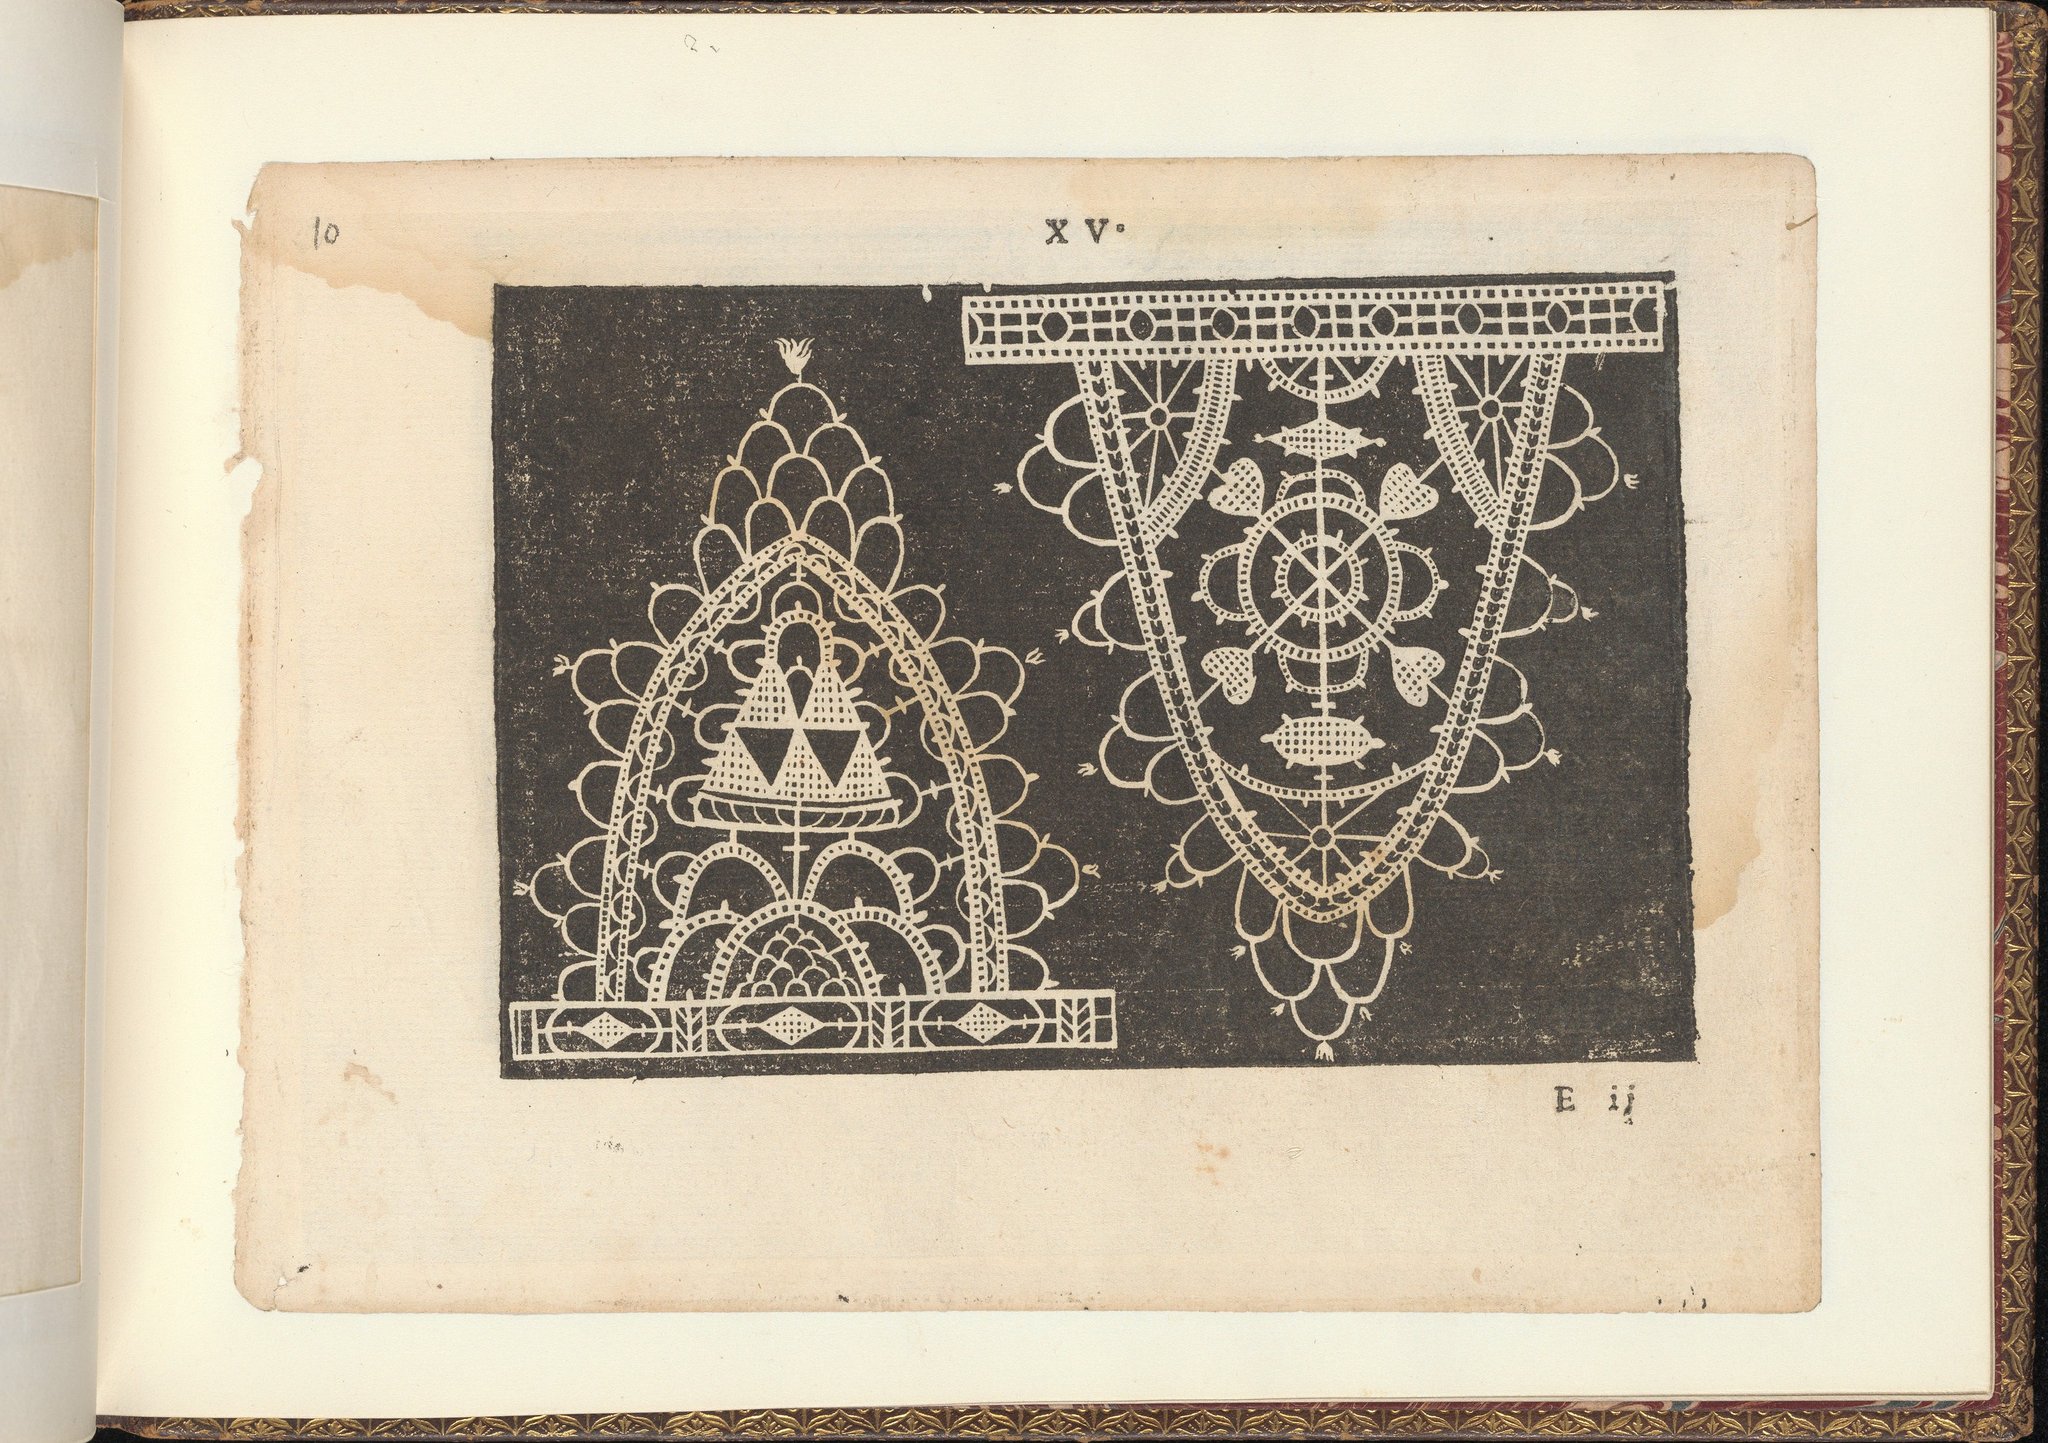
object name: book print ornament architecture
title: Prima parte de' fiori, page 11 (recto)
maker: giovanni battista ciotti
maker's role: author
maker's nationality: italian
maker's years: 1555-1659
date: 1591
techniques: woodcut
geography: italy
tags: ornament